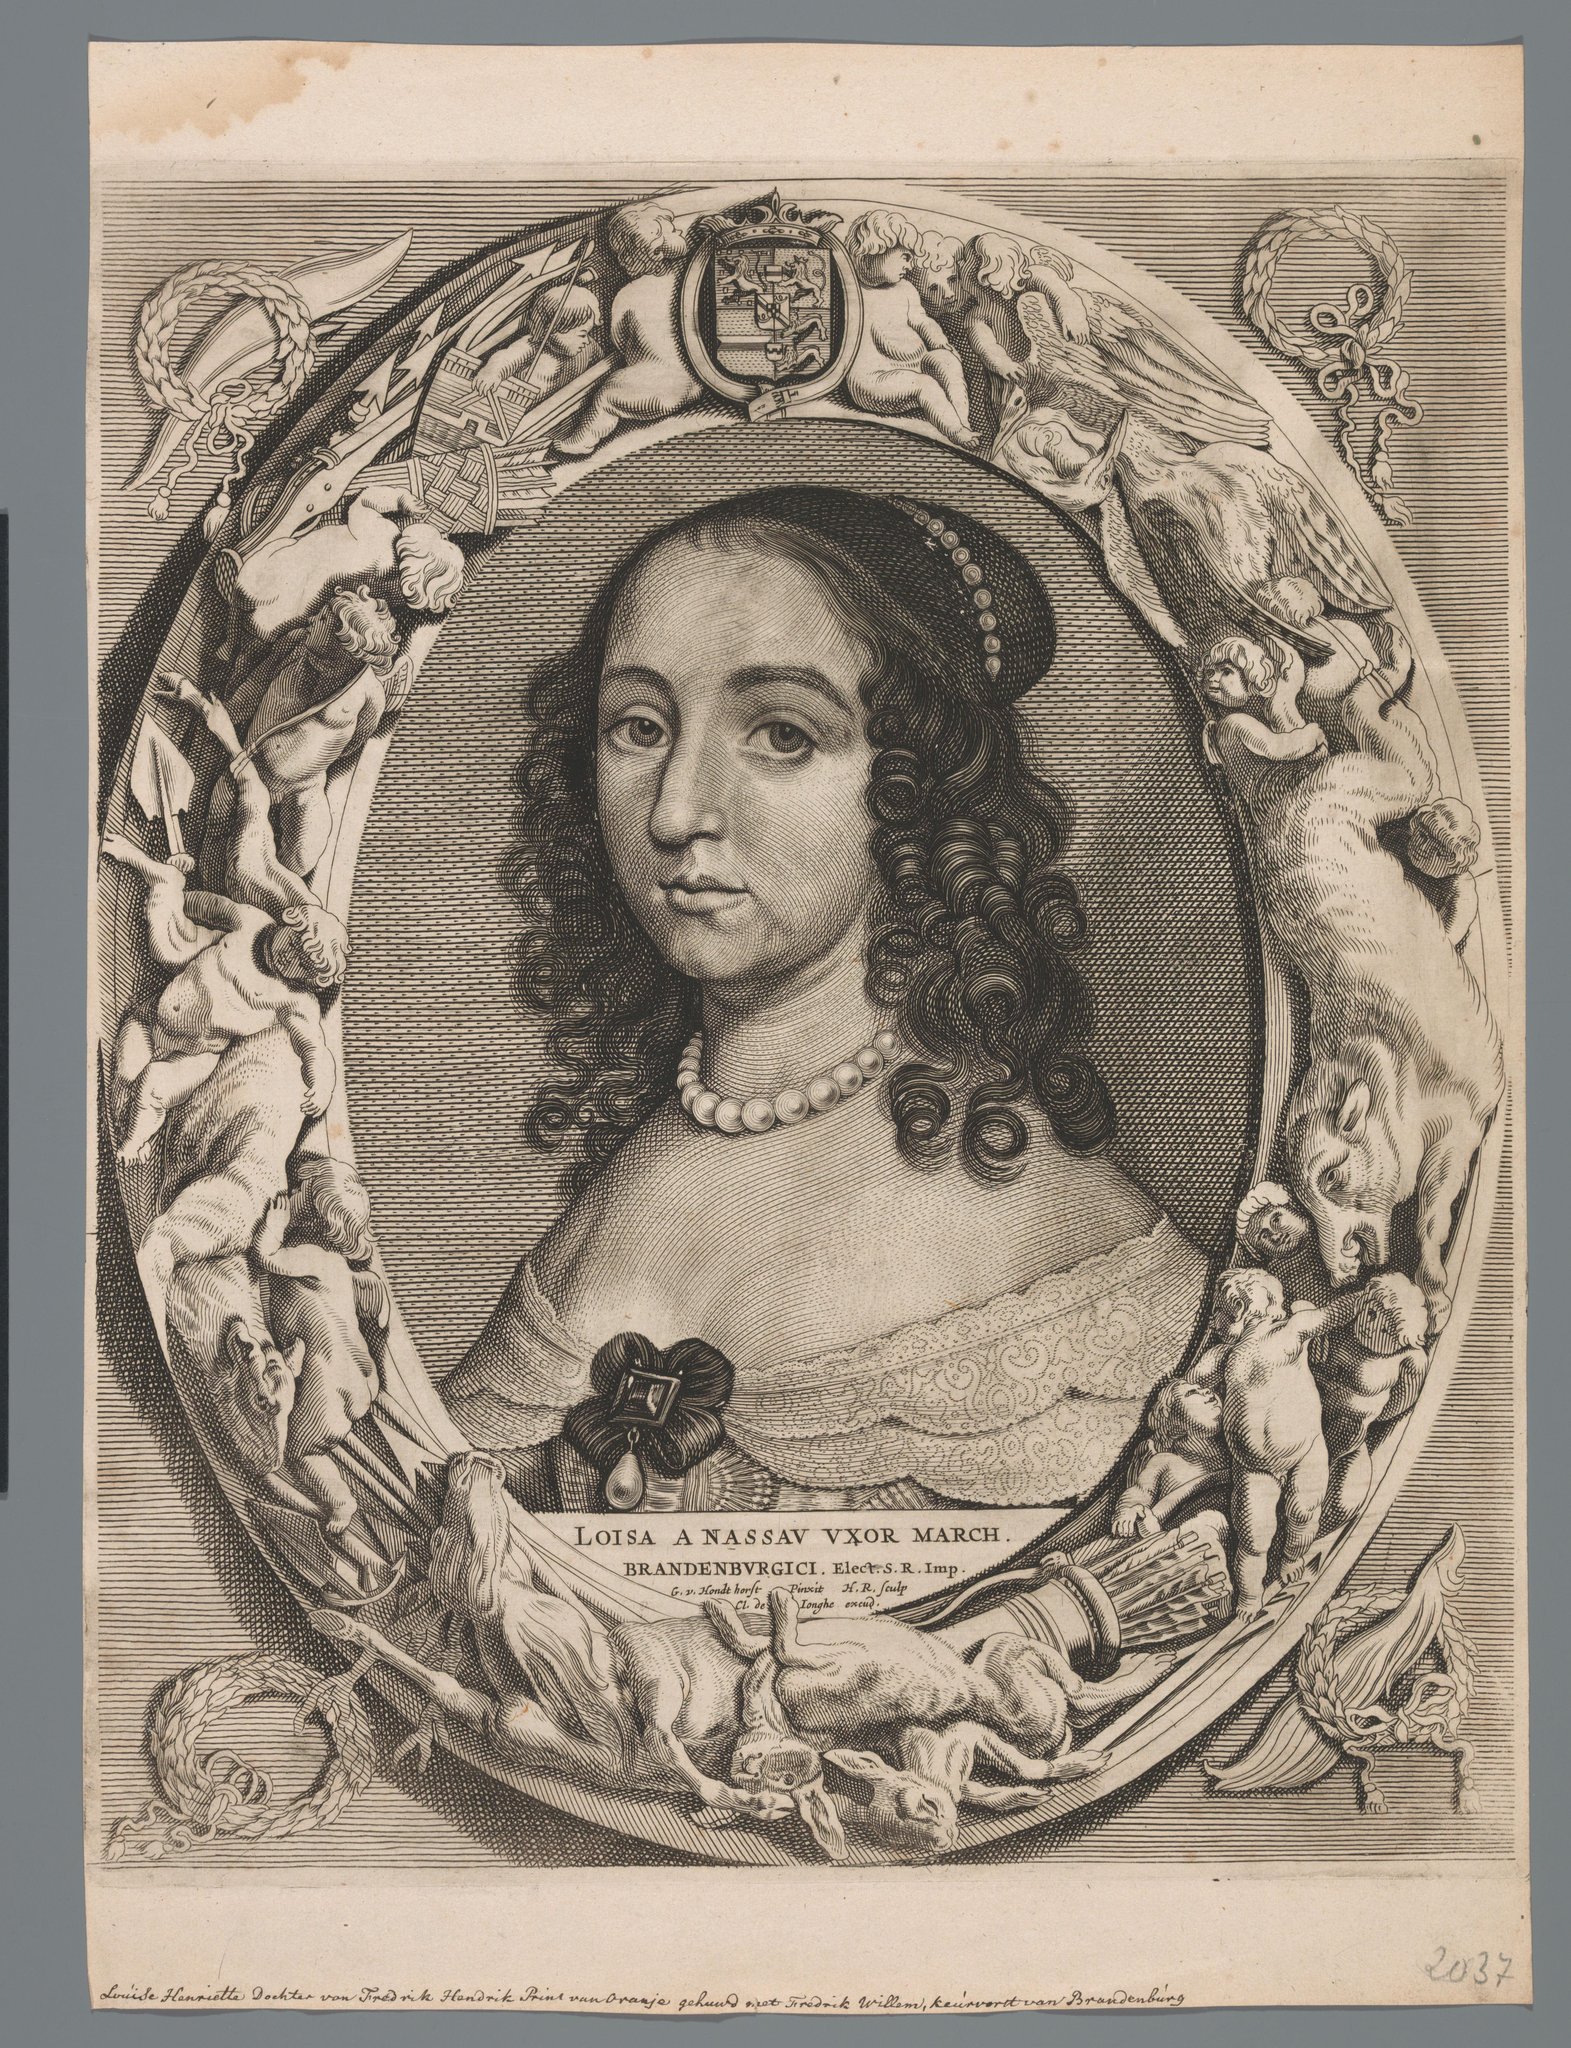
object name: print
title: Portret van Louise Henriëtte, prinses van Oranje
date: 1649-1677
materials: paper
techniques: engraving, etching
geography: amsterdam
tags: the hague, berlin, louise henriëtte (prinses van oranje)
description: De hier vermelde titel verwijst naar de hoogst verkregen titel van de geportretteerde, niet per se naar de titel die de geportretteerde op deze voorstelling draagt. Tegenzijdige kopie naar de prent van Cornelis de Visscher in de serie Fredericvs Henricvs Illvstrissimvs Orangiae Princeps ..., verschenen onder supervisie van Pieter Soutman in 1649. De figuren zijn gebaseerd op het schilderij van Gerard van Honthorst uit 1647 in de collectie van het Rijksmuseum, SK-A-874.